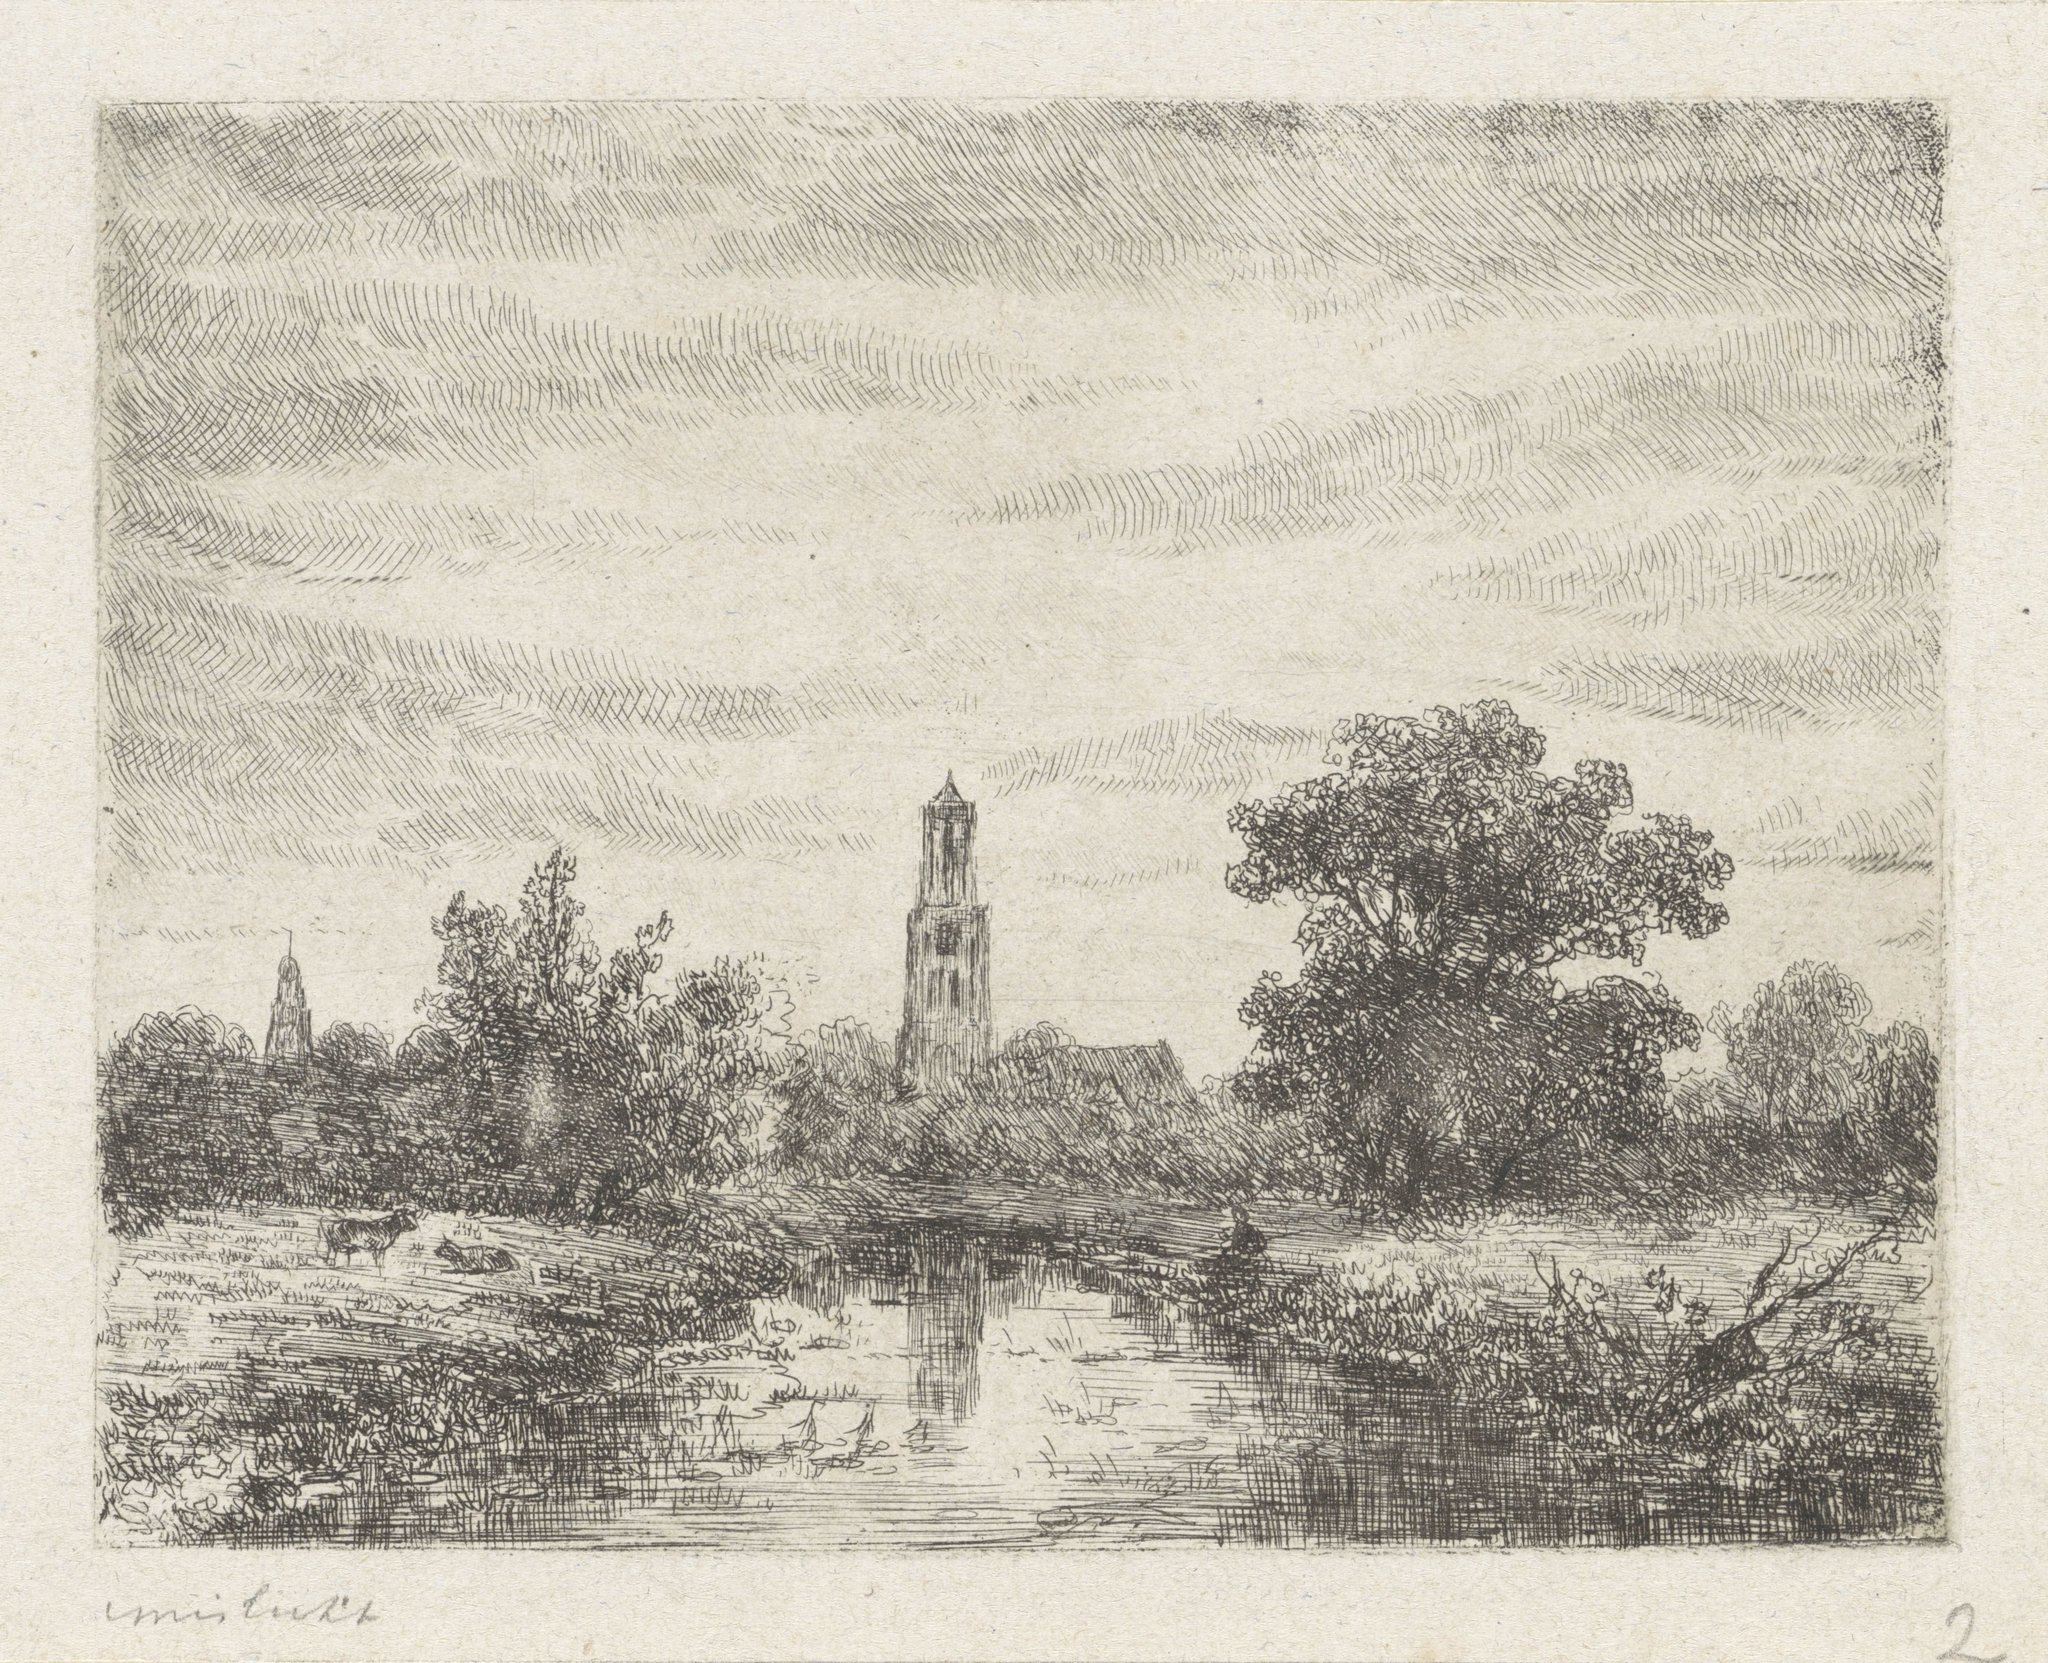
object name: print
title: Gezicht op Utrecht(?)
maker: Anonymous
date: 1830-1882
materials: paper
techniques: etching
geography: netherlands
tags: city-view, and landscape with man-made constructions, cow, river, fisherman, parts of church exterior and annexes: tower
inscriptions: collector's mark: Lugt 2228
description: Rechts vooraan een visser aan de oever van een rivier. Links twee koeien. In de verte een stadsgezicht, Utrecht(?), met twee torens.